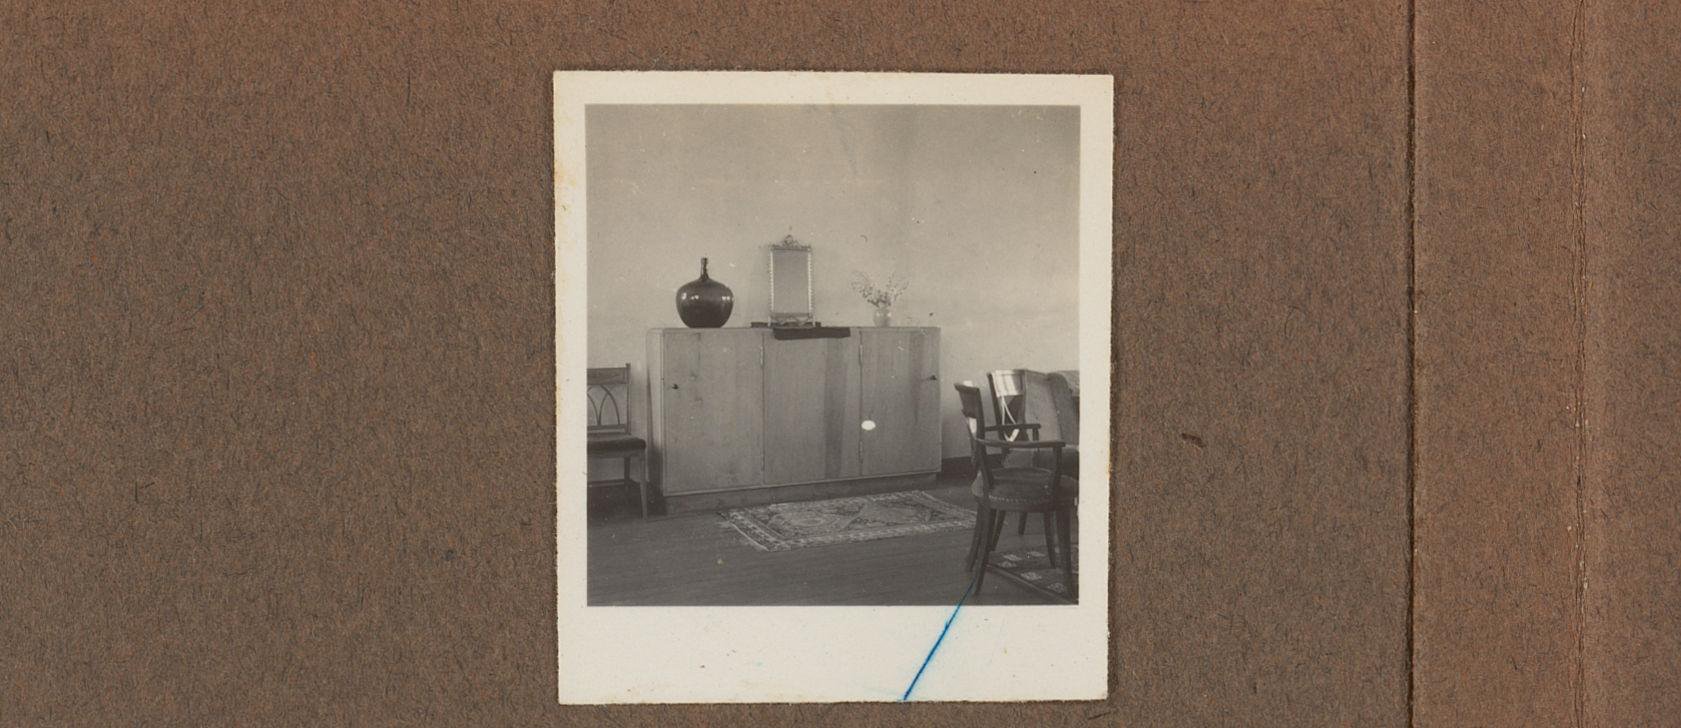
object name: photograph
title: Dressoir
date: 1900-1920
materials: photographic support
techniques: photography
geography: netherlands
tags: amsterdam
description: Foto op bruin albumblad 56 van familiealbum van Alphons Diepenbrock.